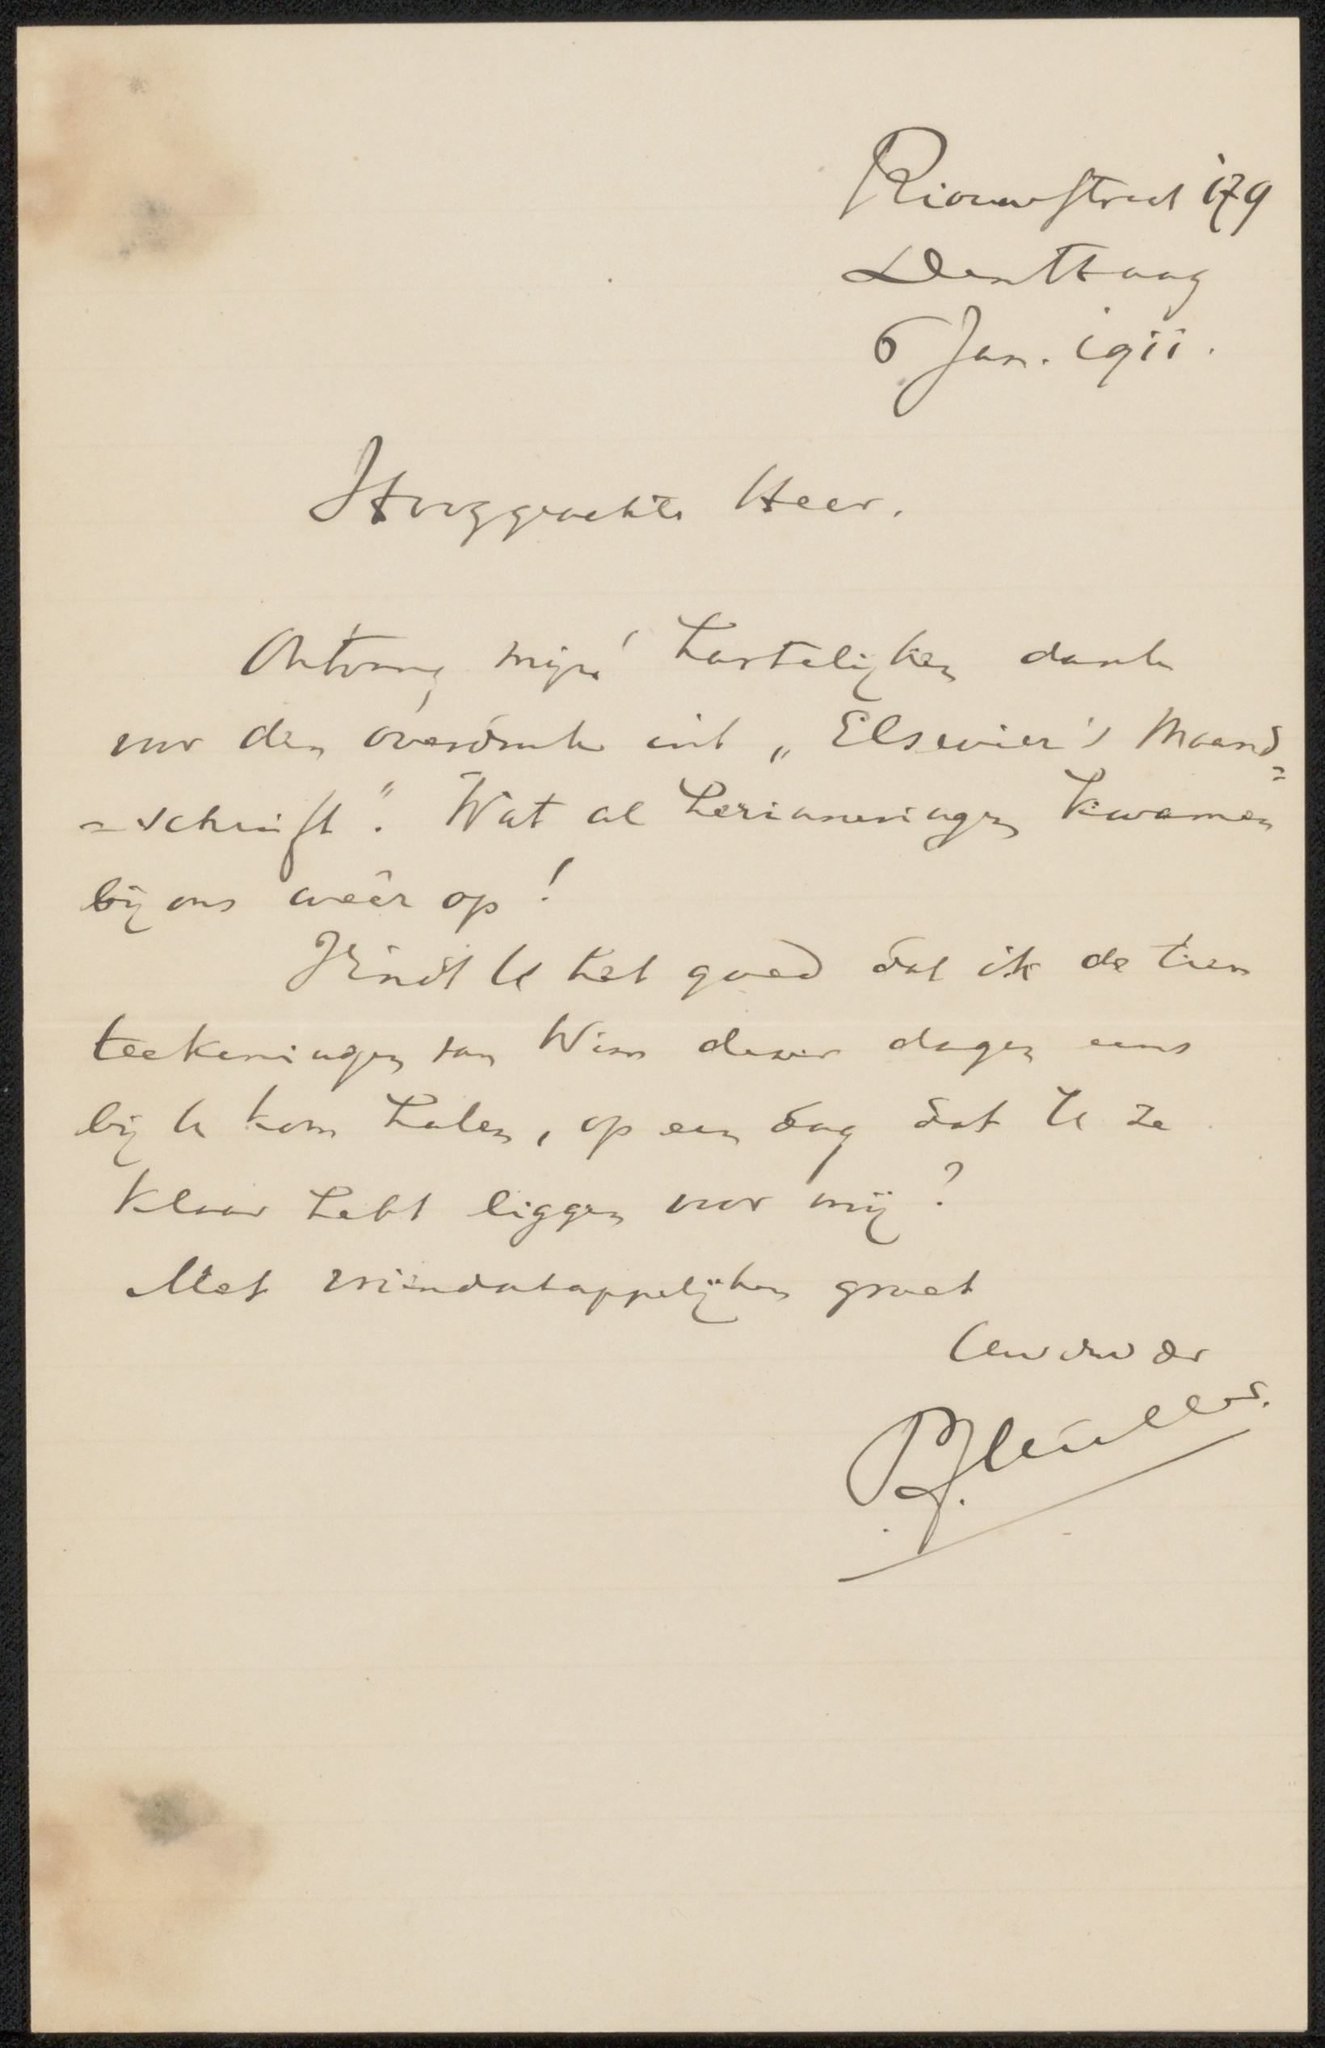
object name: letter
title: Brief aan Philip Zilcken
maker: p.j. muller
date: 1911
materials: ink, paper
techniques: pen, writing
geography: the hague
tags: wim muller, the hague, painter, philip zilcken, drawing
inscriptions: collector's mark: ‘RPK’